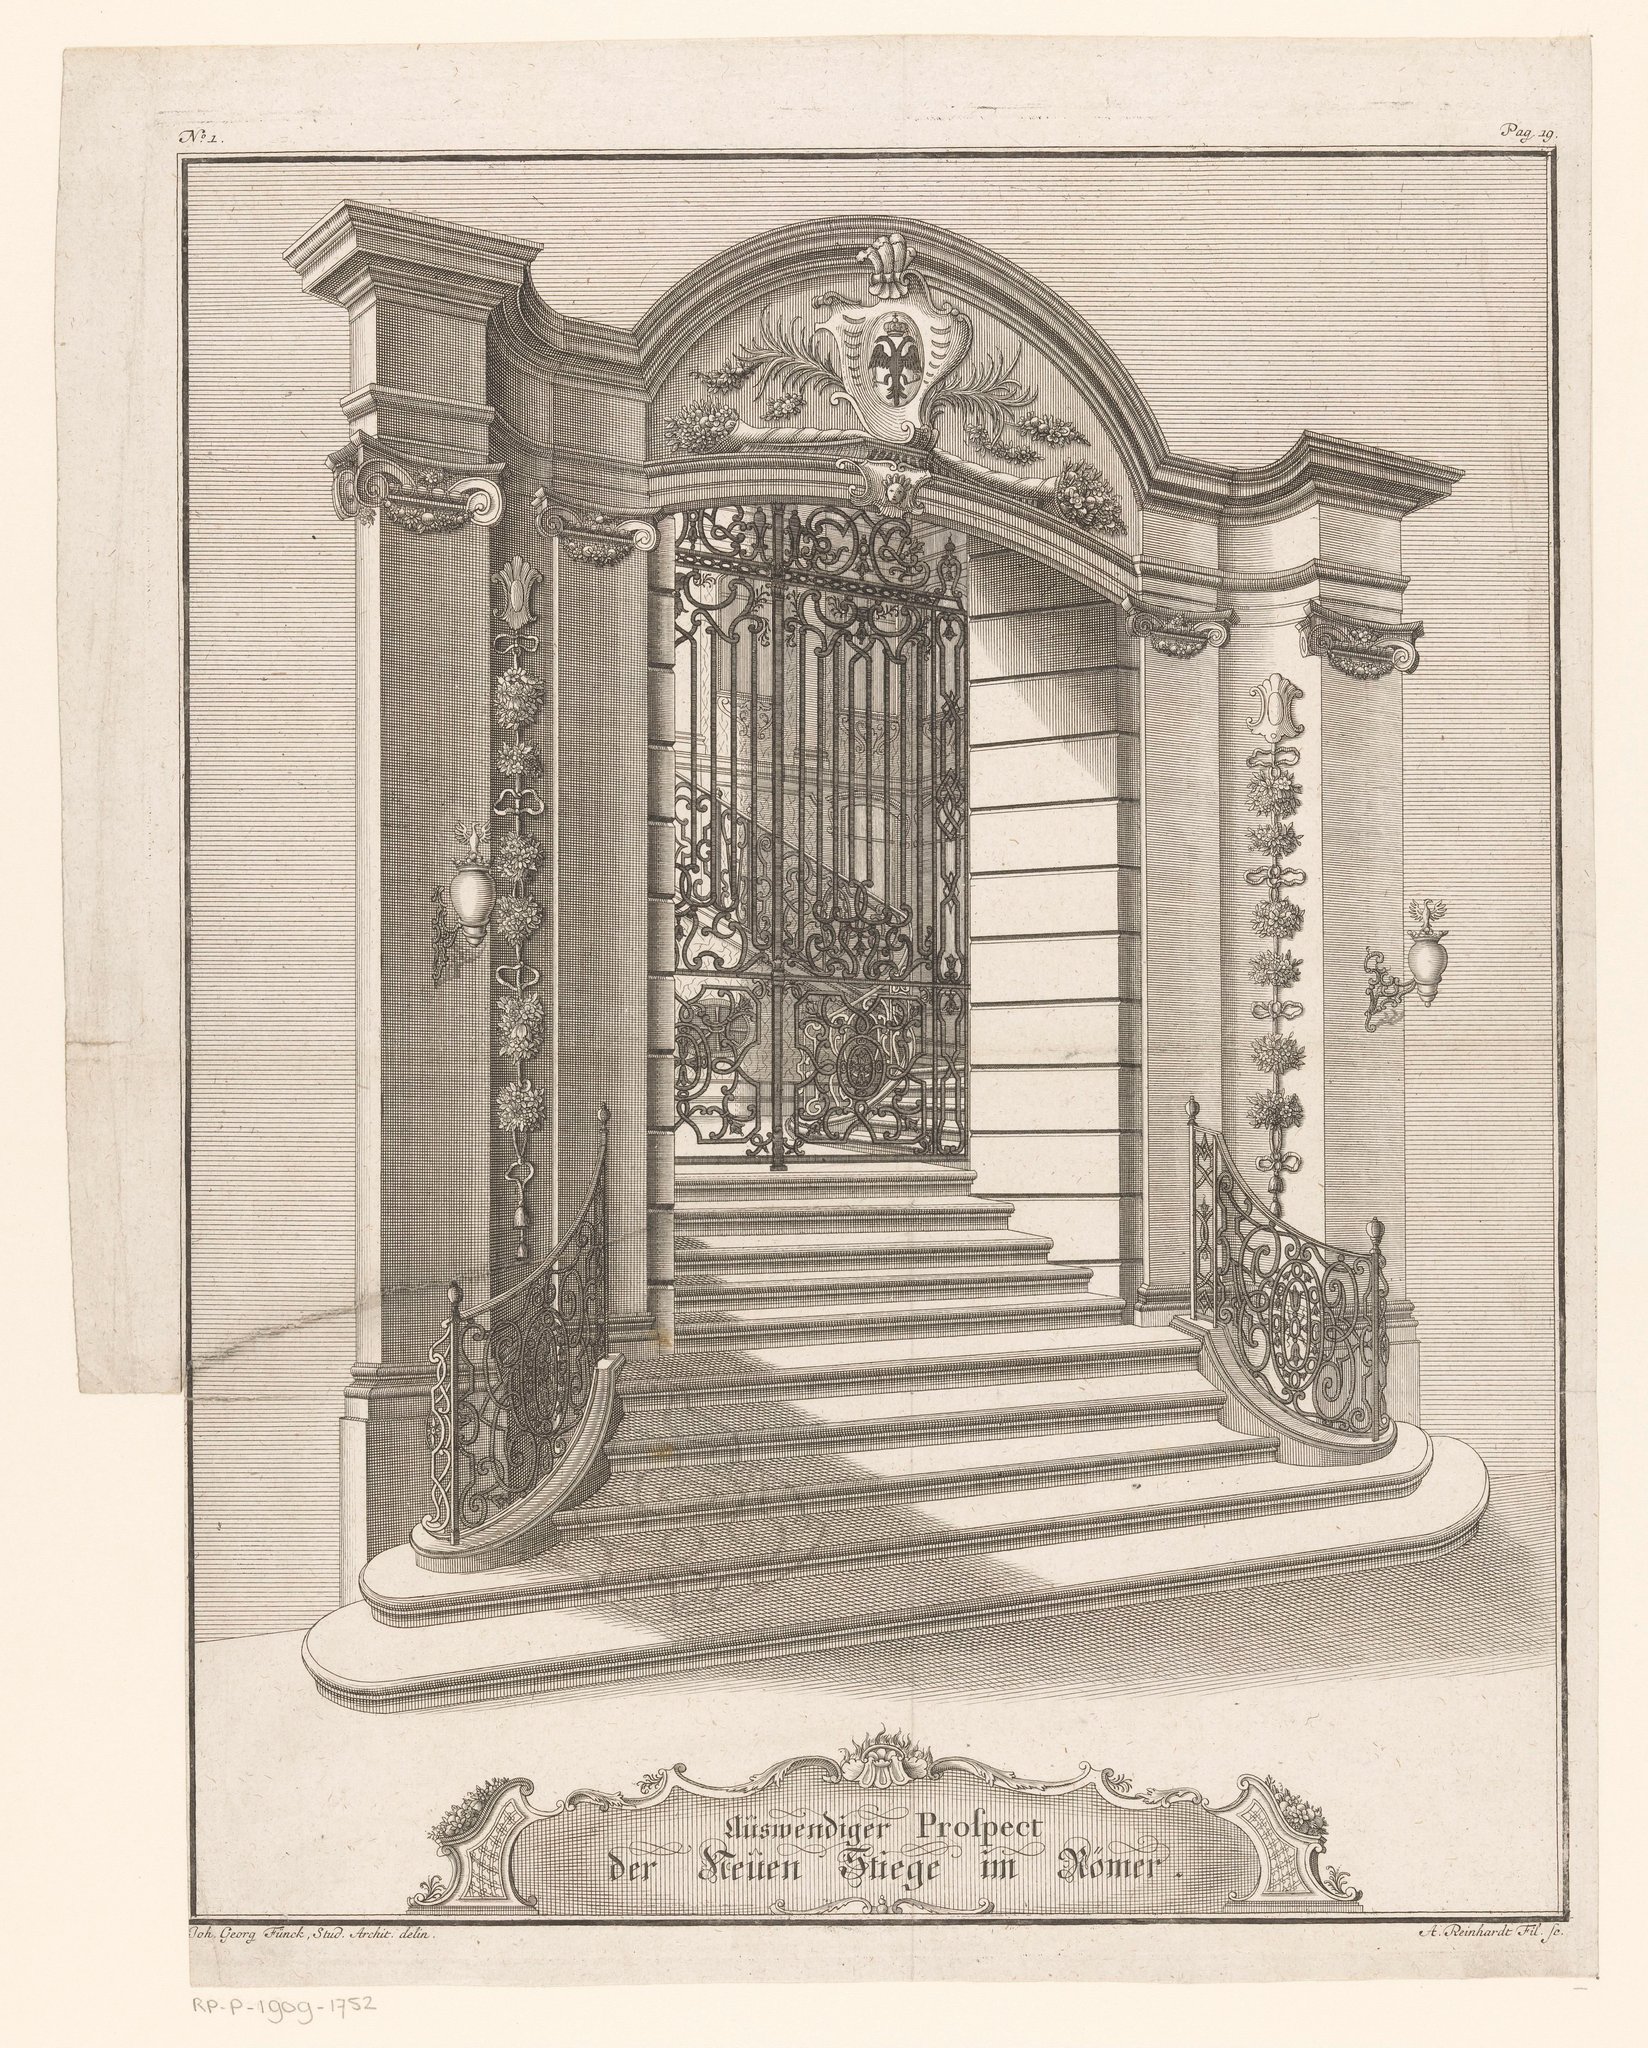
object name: print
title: Buitenzijde van trap in het stadhuis van Frankfurt am Main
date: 1742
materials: paper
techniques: engraving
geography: frankfurt am main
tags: townhall, exterior ~ representation of a building, front steps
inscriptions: collector's mark: Lugt 2228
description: Ingang naar de keizerlijke trap in het stadhuis (Römer) van Frankfurt am Main. De trap wordt middels een smeedijzeren hek afgesloten van de buitenzijde. Aan de bovenzijde hoornen des overvloeds en een rocaille wapenschild met het wapen van het Heilige Roomse Rijk. Rechts boven Pag 19.